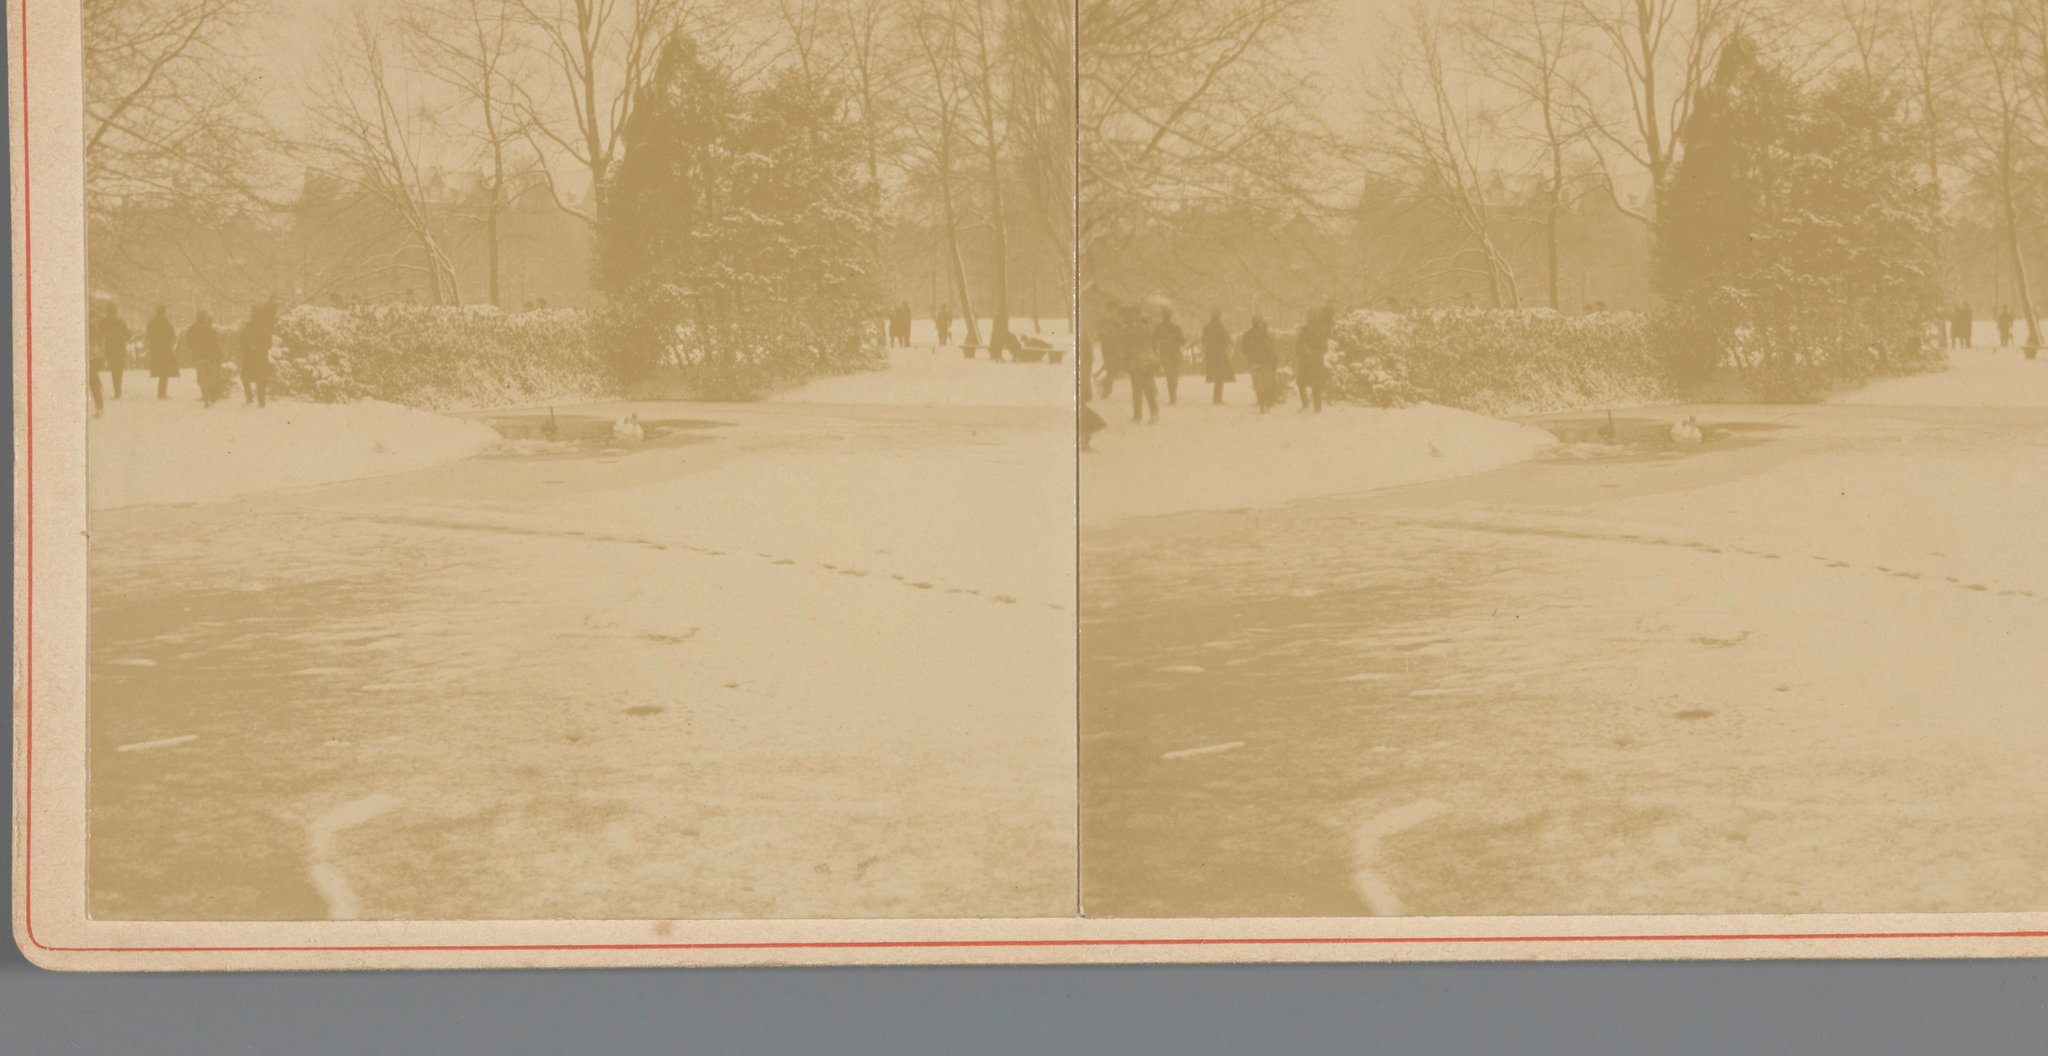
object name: stereograph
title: Vondelpark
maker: Anonymous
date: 1900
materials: cardboard, photographic support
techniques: gelatin silver print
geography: amsterdam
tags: vondelpark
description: Het Vondelpark te Amsterdam, in de sneeuw. Onderdeel van een groep van 5 foto's en 19 stereofoto's gemaakt door een onbekende amateurfotograaf rond 1900 in Amsterdam, de Ardennen en Denemarken.